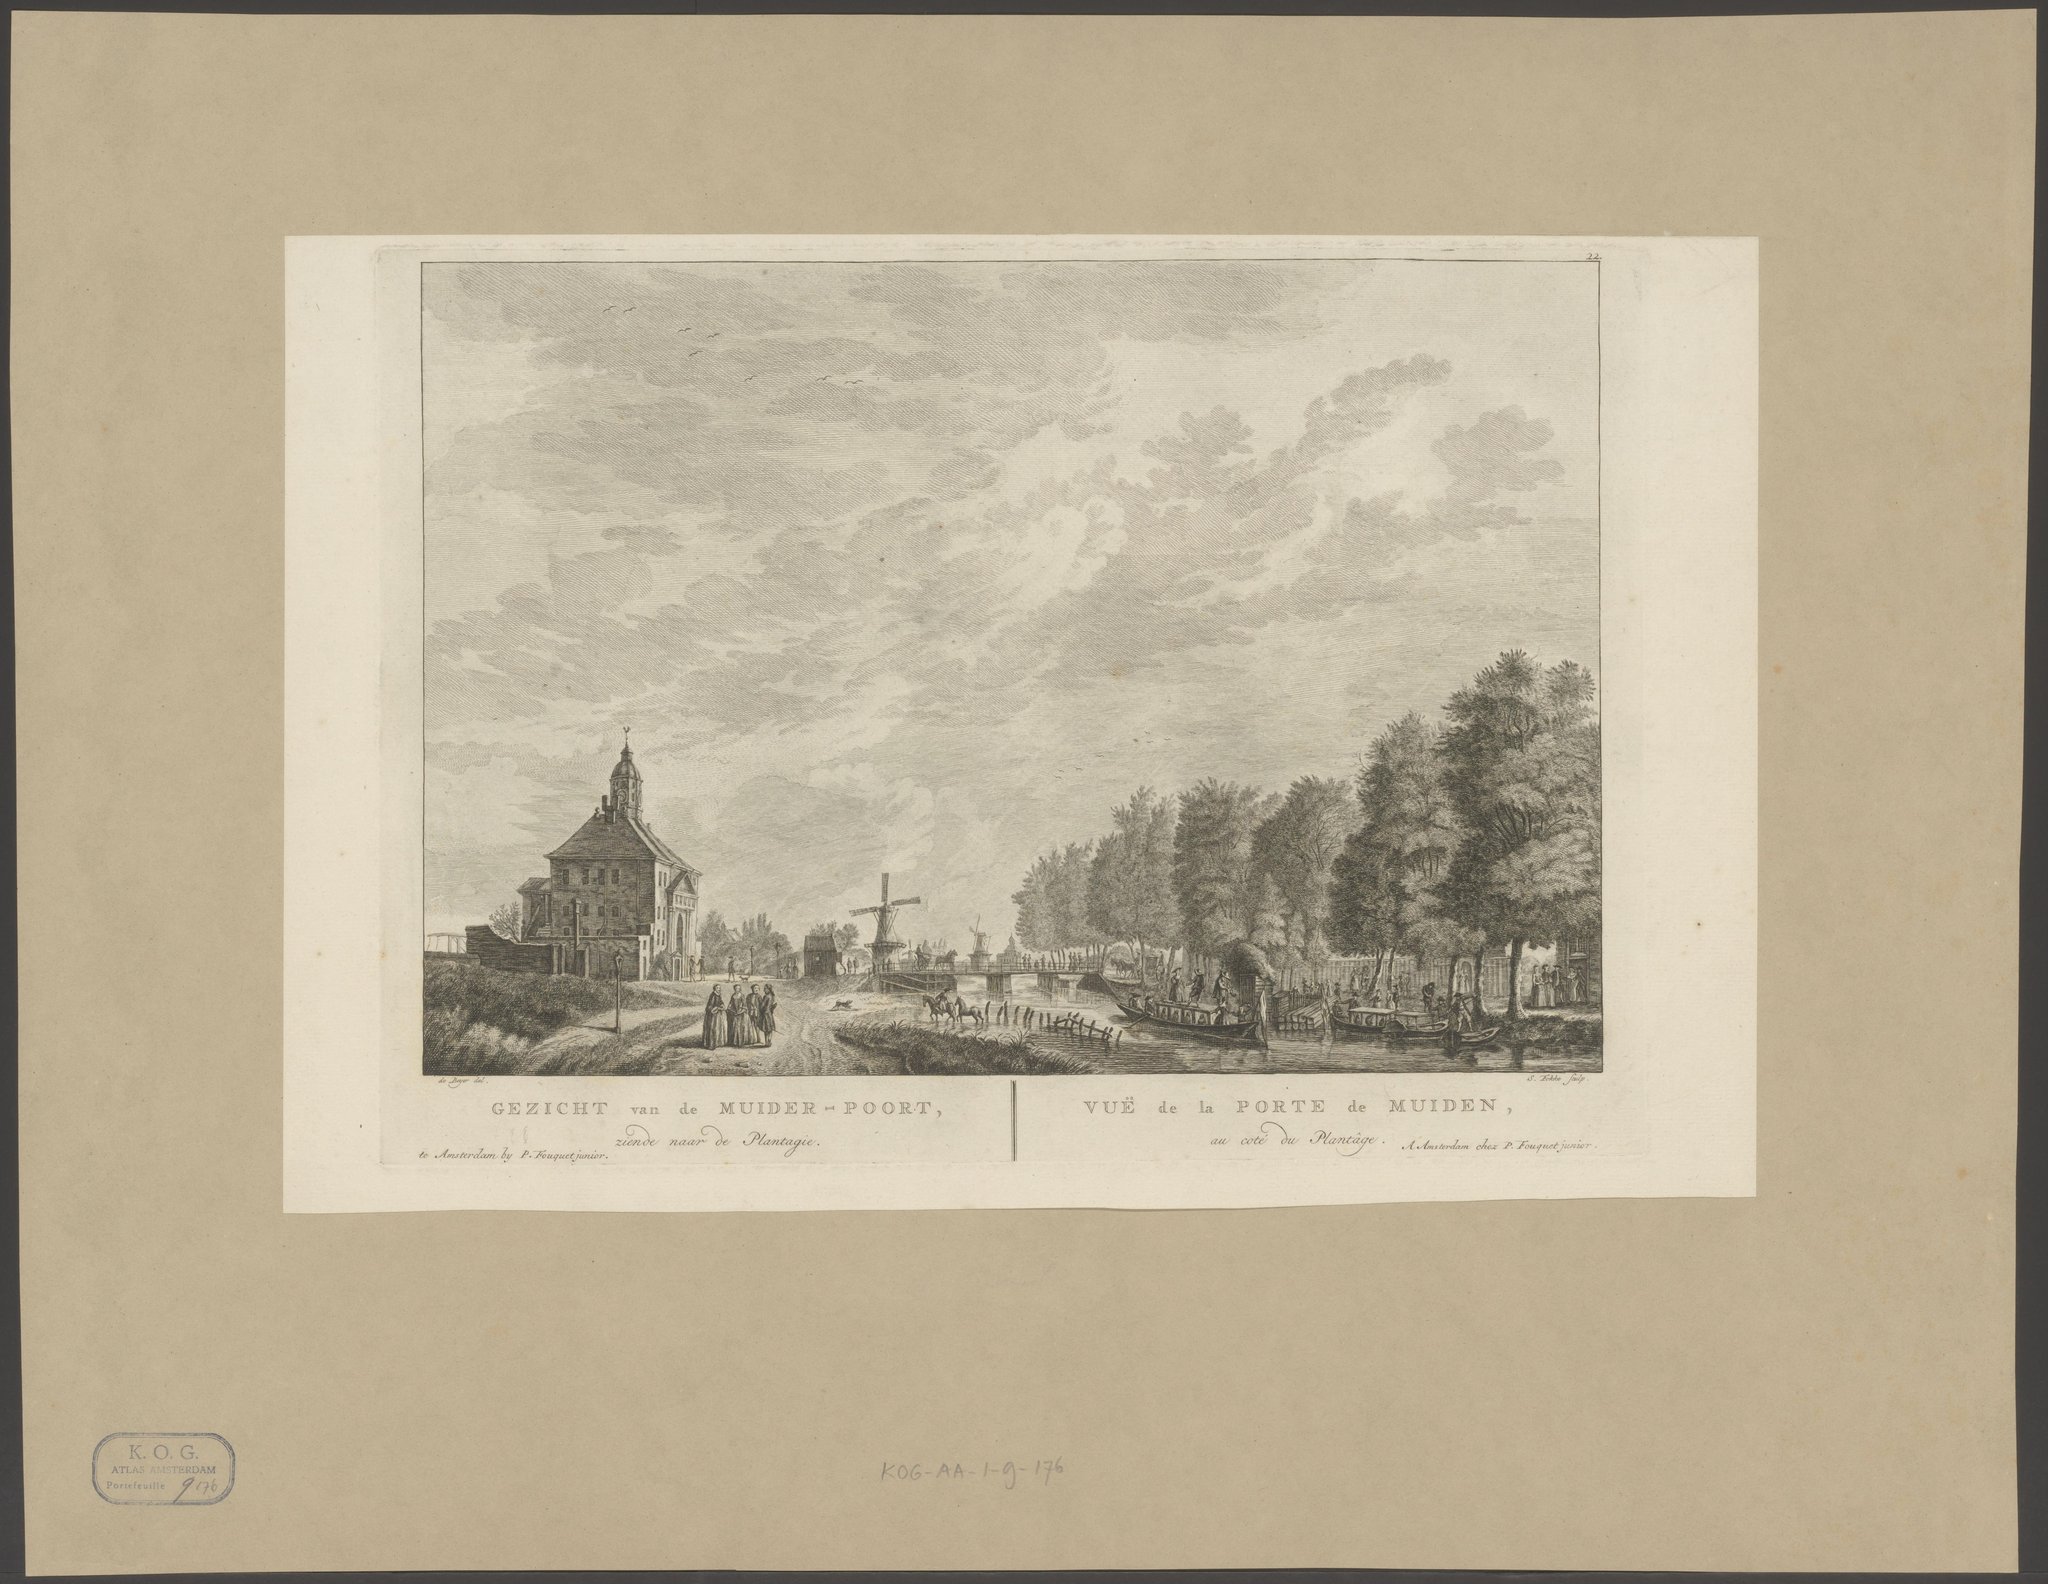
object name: print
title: Gezicht op de Eerste Muiderpoort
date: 1760-1769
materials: paper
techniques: engraving, etching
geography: amsterdam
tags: city-view in general; 'veduta', canal, windmill in landscape, city-gate, boat propelled by man or animal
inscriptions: collector's mark: ‘9.176’ Lugt 1641b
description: Deze prent is ook gebruikt in de zogenaamde Atlas van Fouquet.* Pierre Fouquet gaf vanaf 1760 stadsgezichten van Amsterdam - naar tekeningen van verschillende kunstenaars, gemaakt door verschillende prentmakers - uit. Deze prenten werden aanvankelijk los of in series verkocht. Zoals toen gebruikelijk kon de koper de prenten zelf laten inbinden. Hiertoe gaf Fouquet tussen 1778 en 1783 een titelblad, plattegrond en inhoudsopgave van de tot dusver 100 uitgegeven prenten uit (1). Gezien de inhoud afhankelijk was van wat de koper had verzameld verschilt de inhoud van de verschillende bewaarde Fouquetatlassen onder deze titel sterk. Ook zijn er exemplaren bekend waar tevens andere prenten aan zijn toegevoegd. Omdat er behoefte bleek aan uitleg bij de platen werd in 1783 een nieuwe versie van de atlas uitgegeven, aangevuld met tekst en twee prenten. De aangegeven volgorde veranderde maar de platen van de al eerder uitgegeven prenten bleven ongewijzigd. Deze uitgave werd in opdracht van Fouquet gedrukt bij Daniël Jean Changuion en Petrus den Hengst (2). Een tiental platen werd bijgewerkt en verscheen, met nieuw impressum, in het vervolg van Wagenaars geschiedenis van Amsterdam, uitgeven door Petrus Conradi en Folkert van der Plaats (3). Een aantal jaar na het overlijden van Fouquet kwam Evert Maaskamp met een nieuwe uitgave van de atlas, met verbeterde tekst en toevoeging van twee prenten. Op alle platen verwijderde hij het oude en liet hij zijn eigen impressum zetten (4). De huidige staat van de prent komt voor in exemplaren van de onder (1) en (2) genoemde werken. * Onder de Atlas van Fouquet of Fouquetatlas verstaan we de hieronder vermelde publicaties (1), (2) en (4). (1). Afbeeldingen van de wyd-vermaarde koopstad Amsterdam benevens des zelvs voornaamste gebouwen en gezigten alle naar het leeven getekend / Receuil des edifices les plus considerables et des plus belles vues, de la fameuse ville d'Amsterdam, dessinées d'après nature. Amsterdam: Pierre Fouquet, 1778-1783. (2). Nieuwe atlas, van de voornaamste gebouwen en gezigten der stad Amsterdam, met derzelver beknopte beschryvingen. 2 delen. Amsterdam: Daniël Jean Changuion en Petrus den Hengst [in opdracht van Pierre Fouquet], 1783. (3). Stijl, Simon. Amsterdam, in zyne geschiedenissen, voorregten, koophandel, gebouwen, kerkenstaat, schoolen, schutterye, gilden en regeeringe, beschreeven. Om te dienen ten vervolge op het werk van Jan Wagenaar (…). 10 delen. Amsterdam en Harlingen: Petrus Conradi en Folkert van der Plaats, 1788-1801. (4). Nieuwe atlas, van de voornaamste gebouwen en gezigten der stad Amsterdam. Met derzelver beknopte beschryvingen. Amsterdam: Evert Maaskamp, 1805. * Het aantal vermelde staten is gebaseerd op het aantal gevonden staten. Mogelijk zijn er meer staten van deze prent.